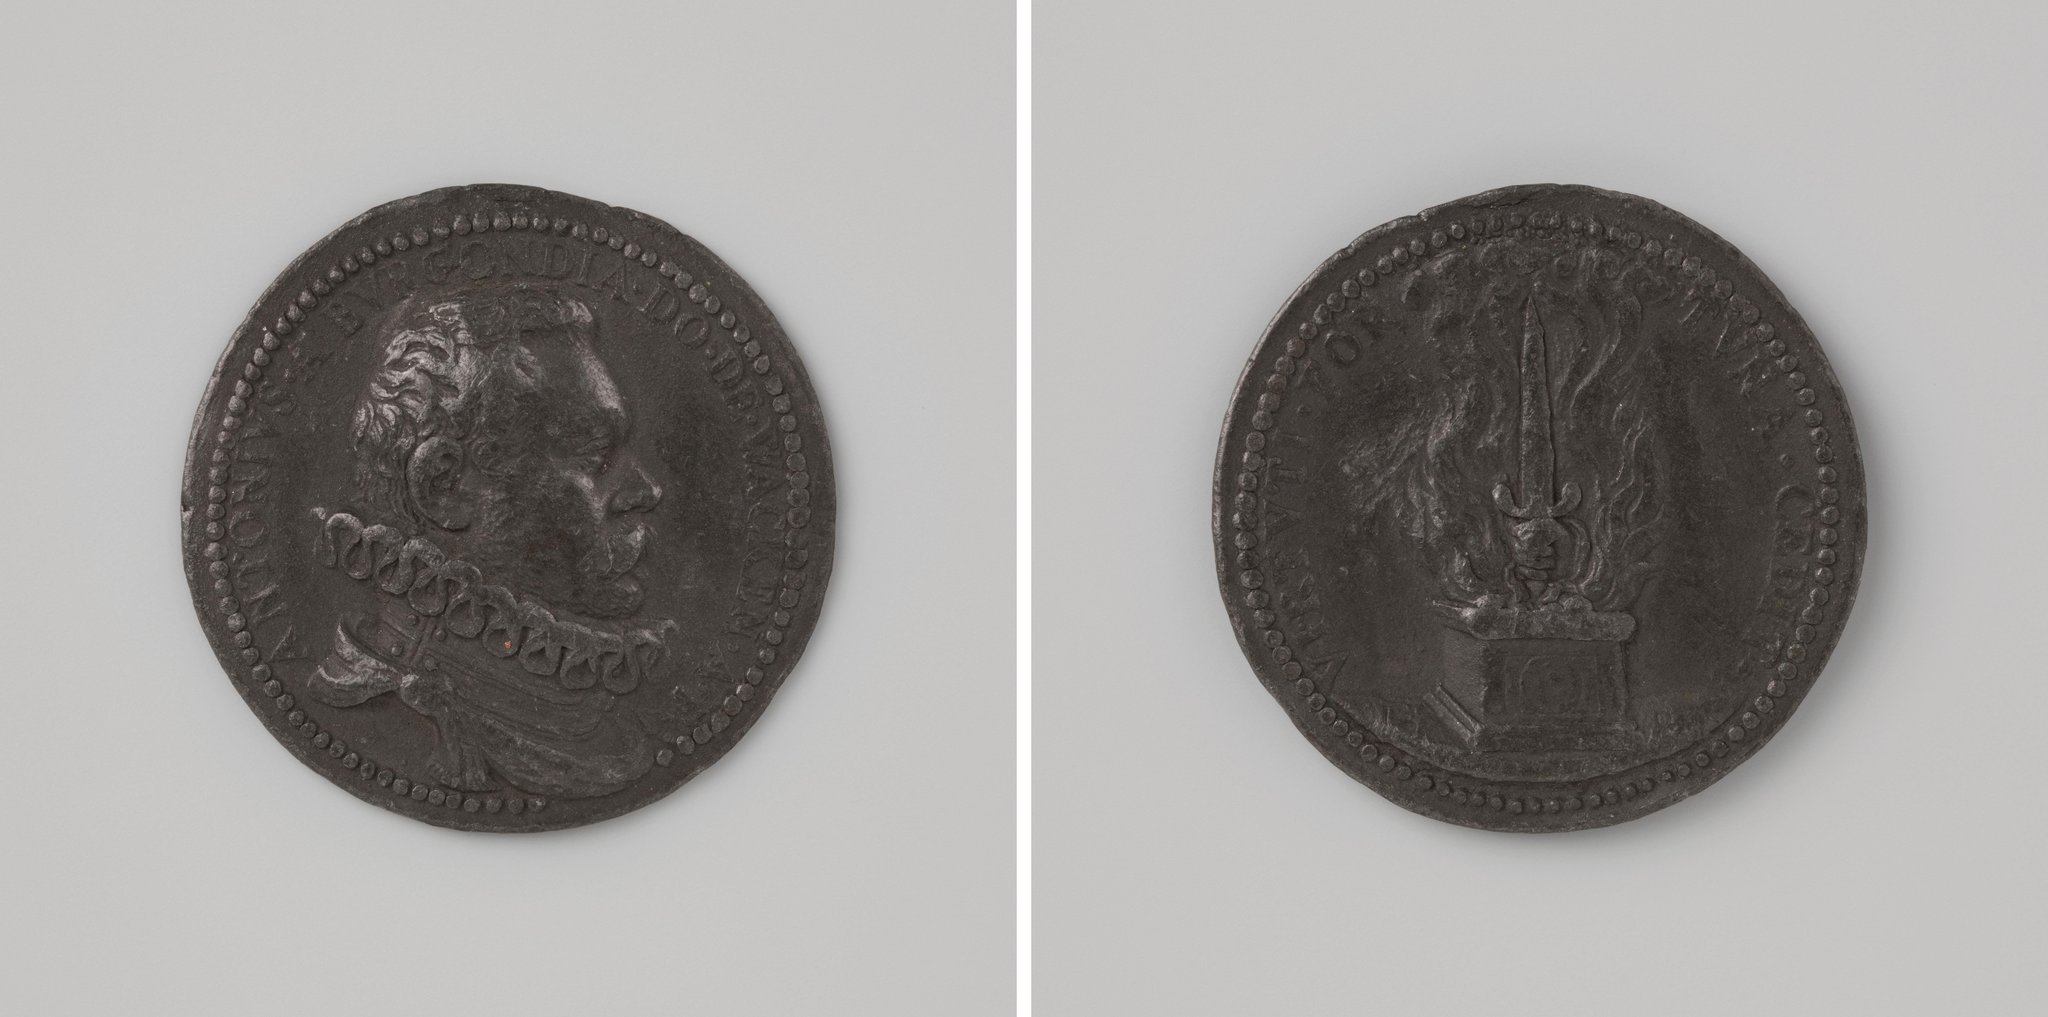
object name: history medal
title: Antonius van Bourgondië admiraal van Vlaanderen en stadhouder van Zeeland (1572)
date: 1572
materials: tin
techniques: casting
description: Tinnen penning, op de voorzijde het geharnaste borstbeeld van Antonius van Borgondië naar rechts met omschrift, op de keerzijde een hand met een zwaard uit een brandend altaar, met omschrift.